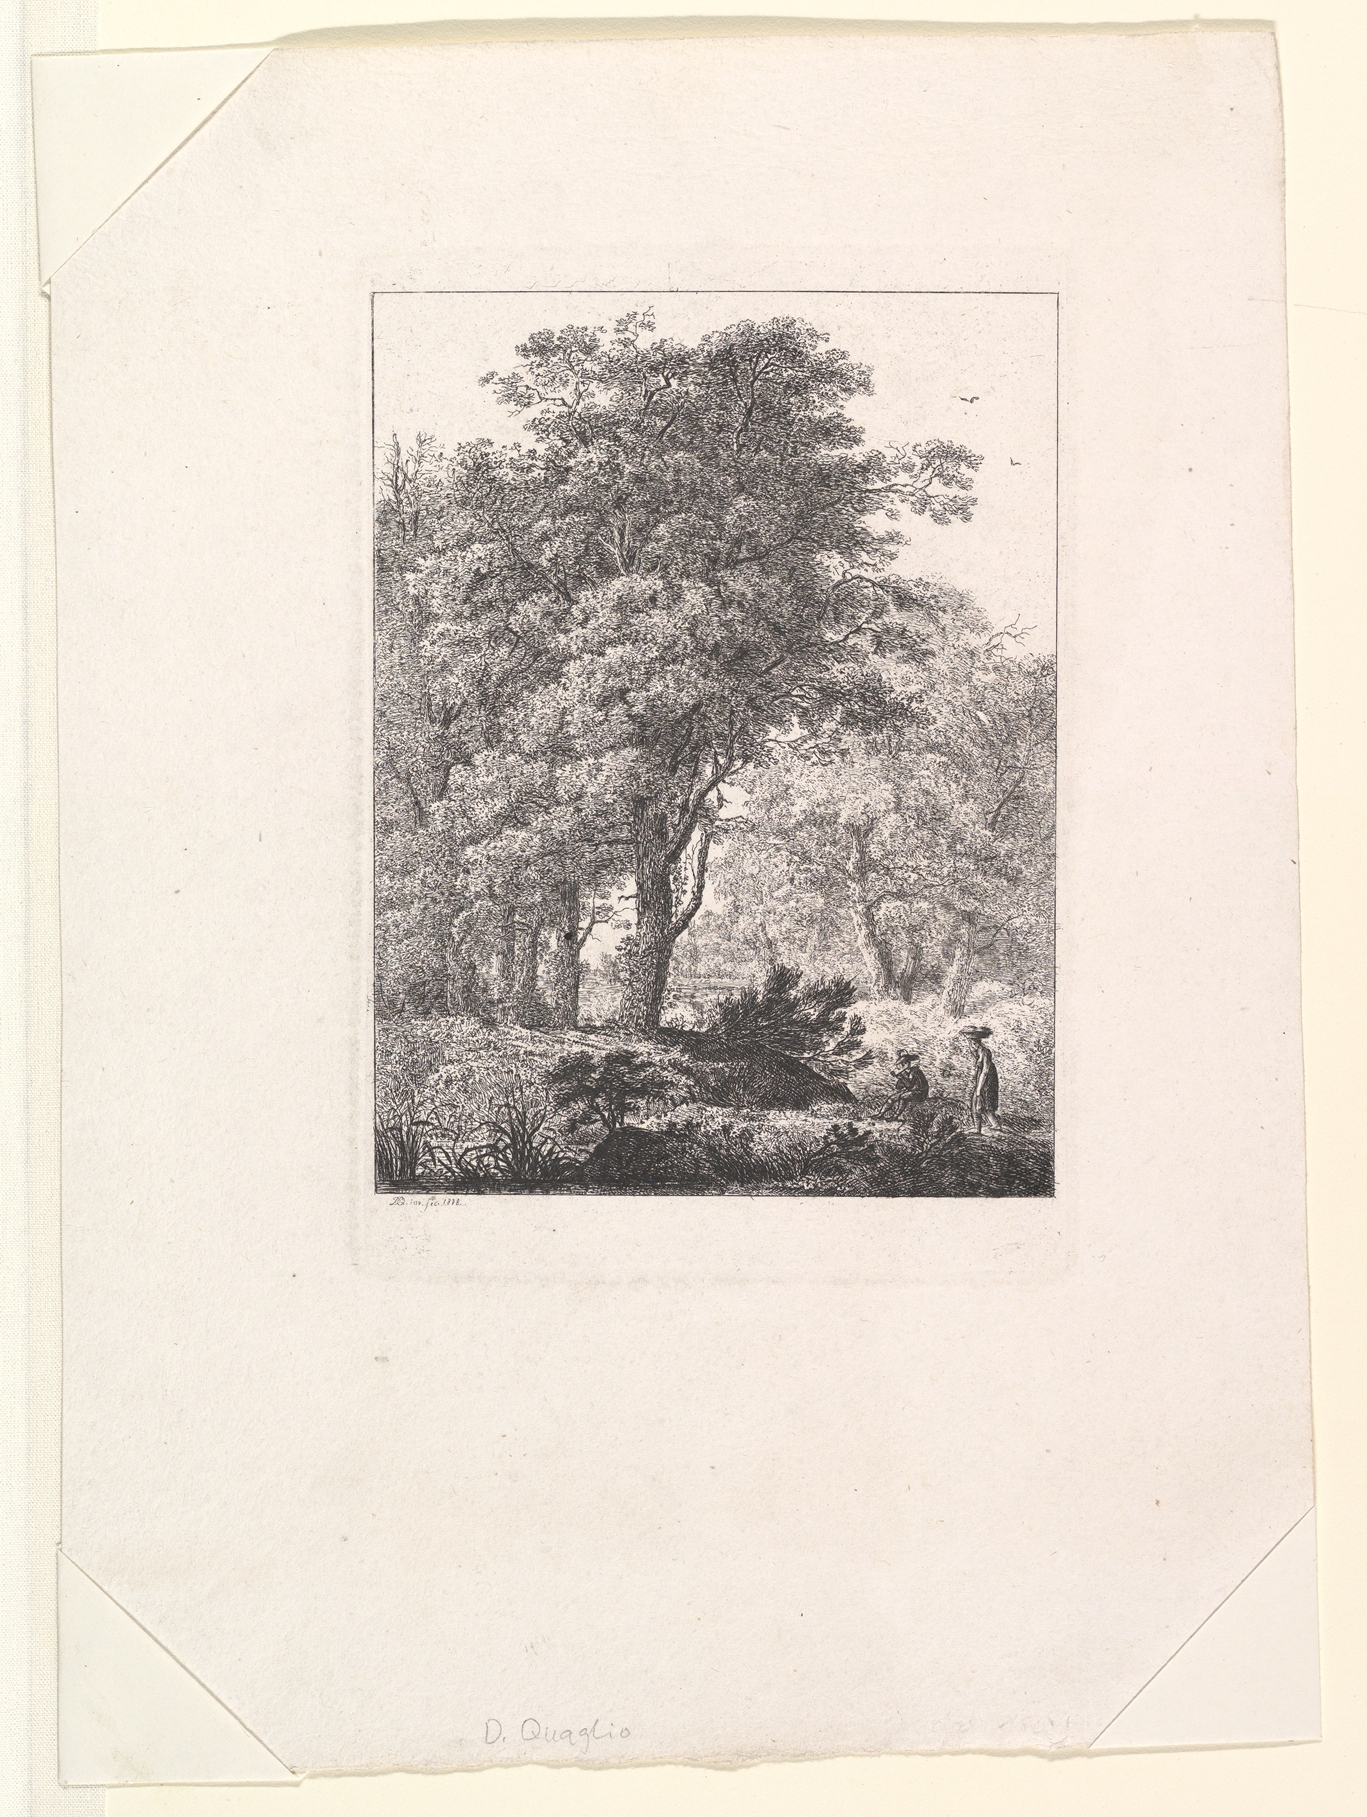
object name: print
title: Forest Landscape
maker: domenico quaglio ii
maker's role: artist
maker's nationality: german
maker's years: 1786-1837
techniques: etching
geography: germany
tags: human figures,forests,landscapes,trees